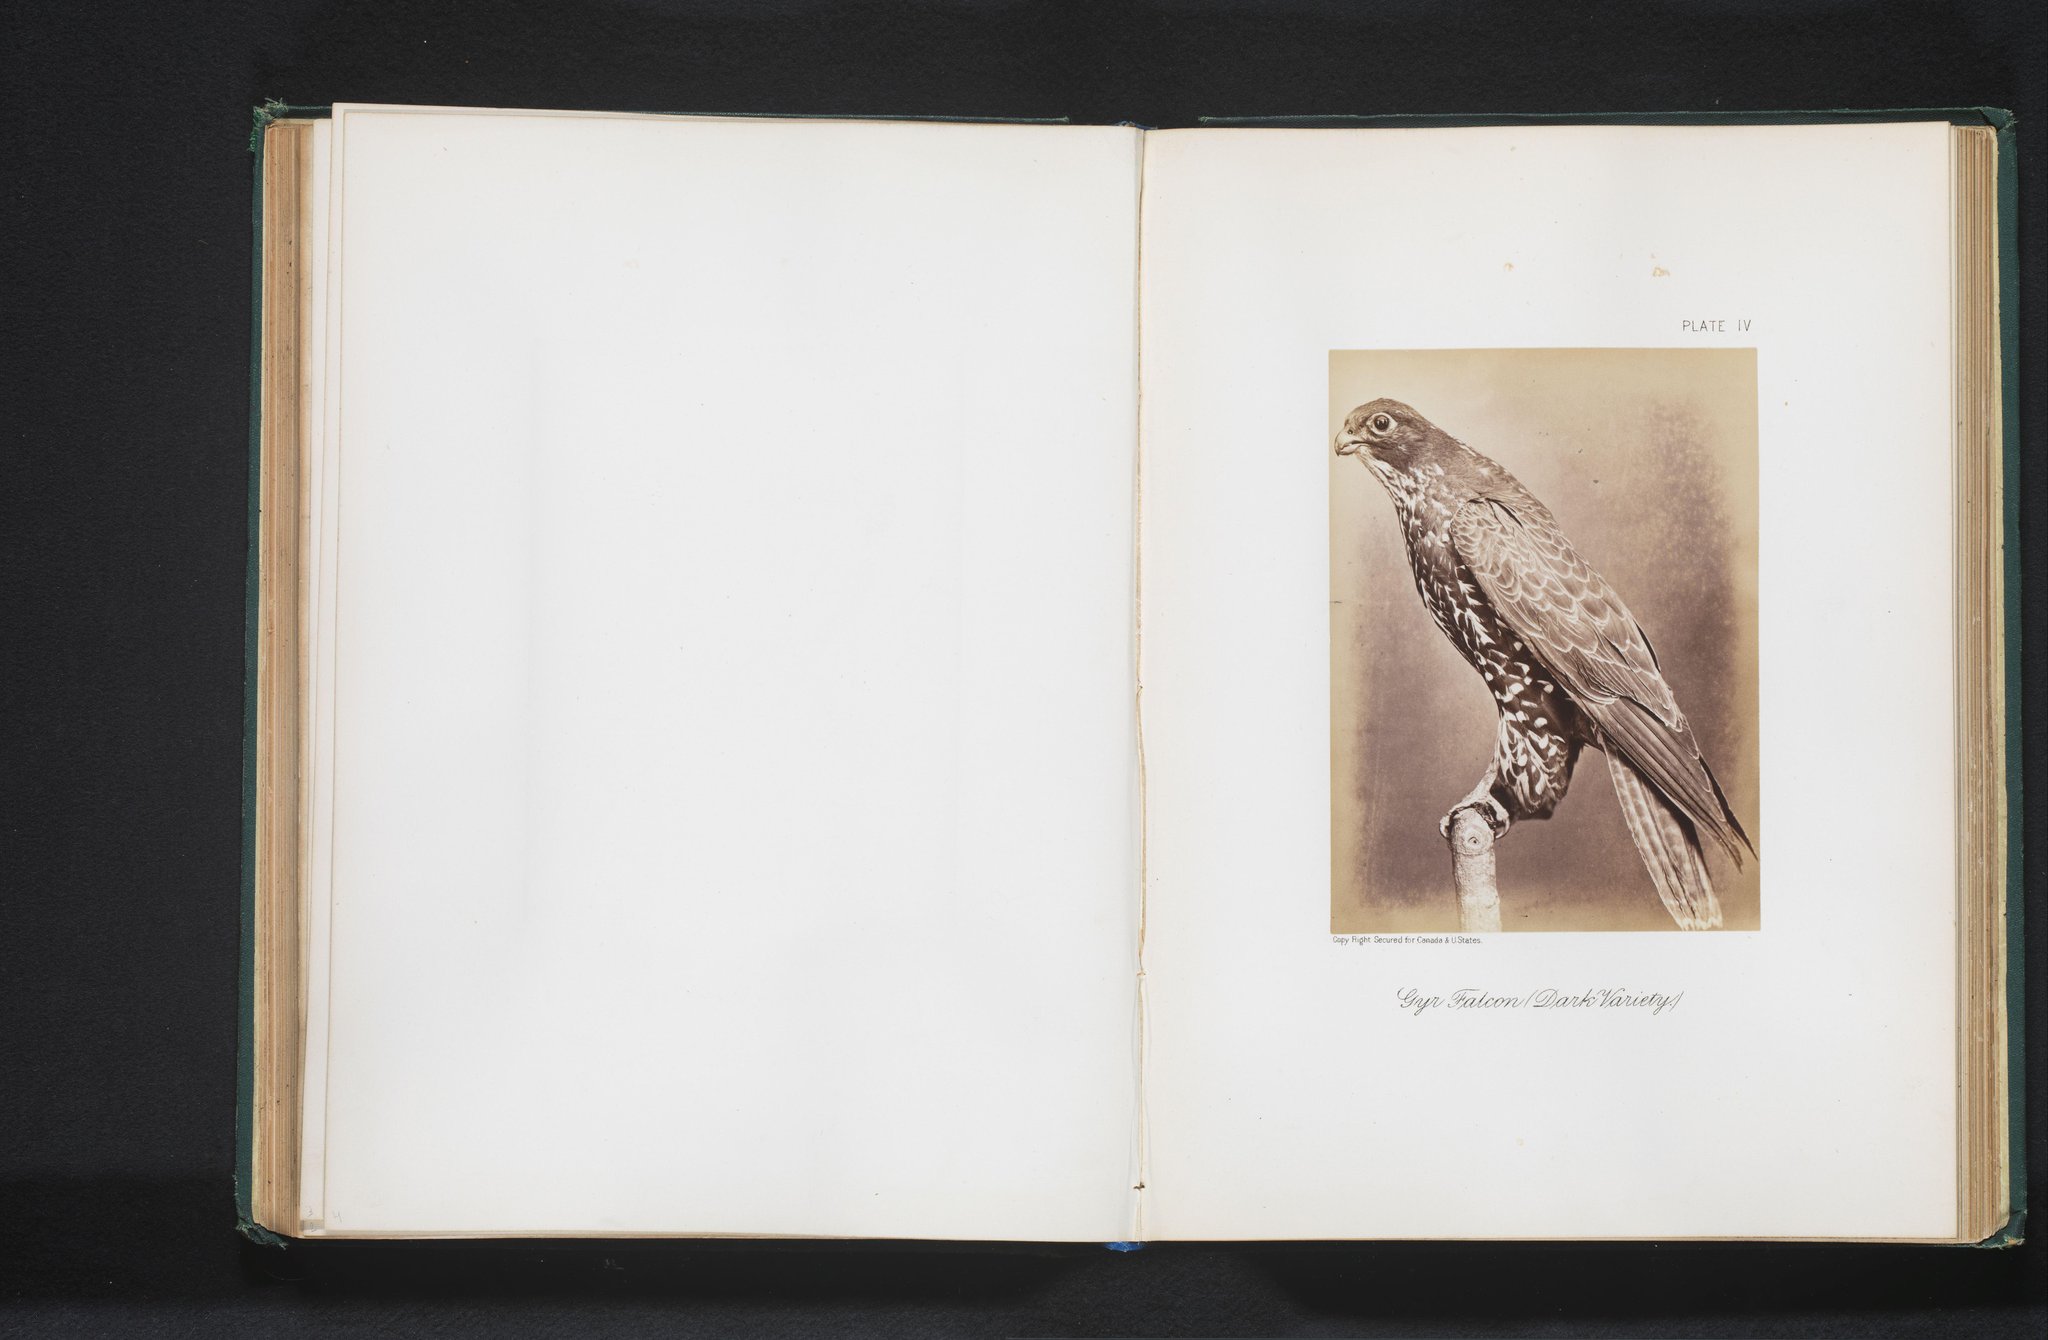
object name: page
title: Gyr Falcon/Dark Variety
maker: william notman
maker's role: fotograaf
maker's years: 1826-1891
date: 1871-1876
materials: paper, photographic support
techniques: albumen print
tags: predatory birds: falcon, collection of animals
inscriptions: number: ‘PLATE IV’, inscription: ‘Copy Right Secured for Canada & U.States’